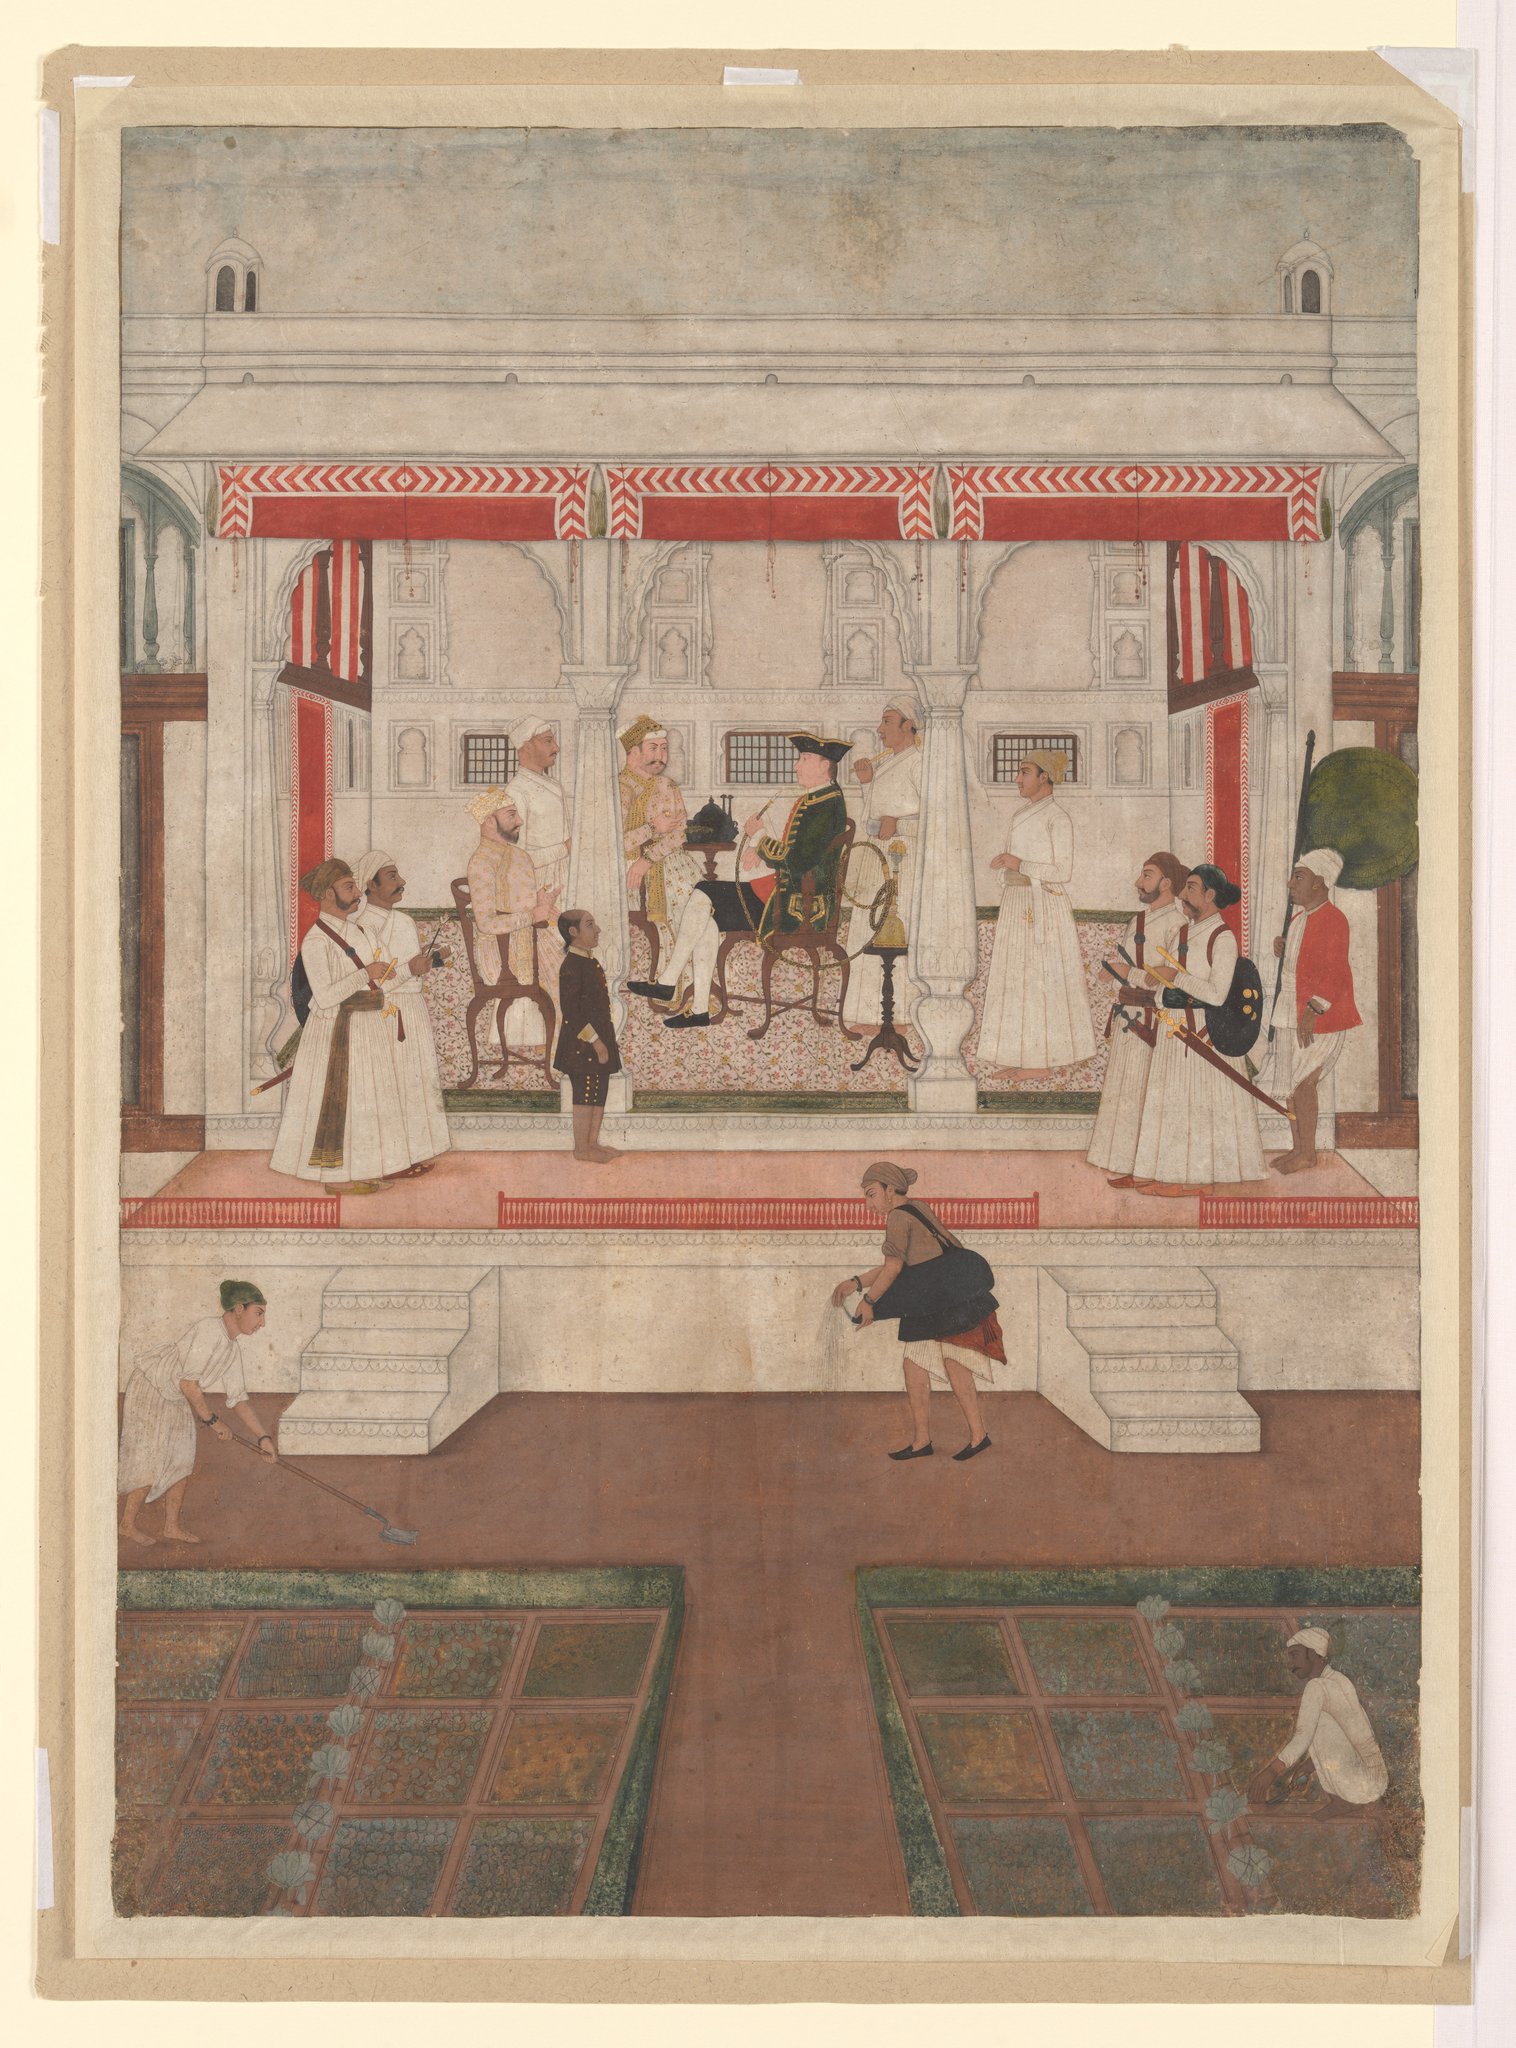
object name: illustrated single work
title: Company Officer Receiving a Nobleman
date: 1760-1765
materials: gold, paper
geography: india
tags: men,smoking